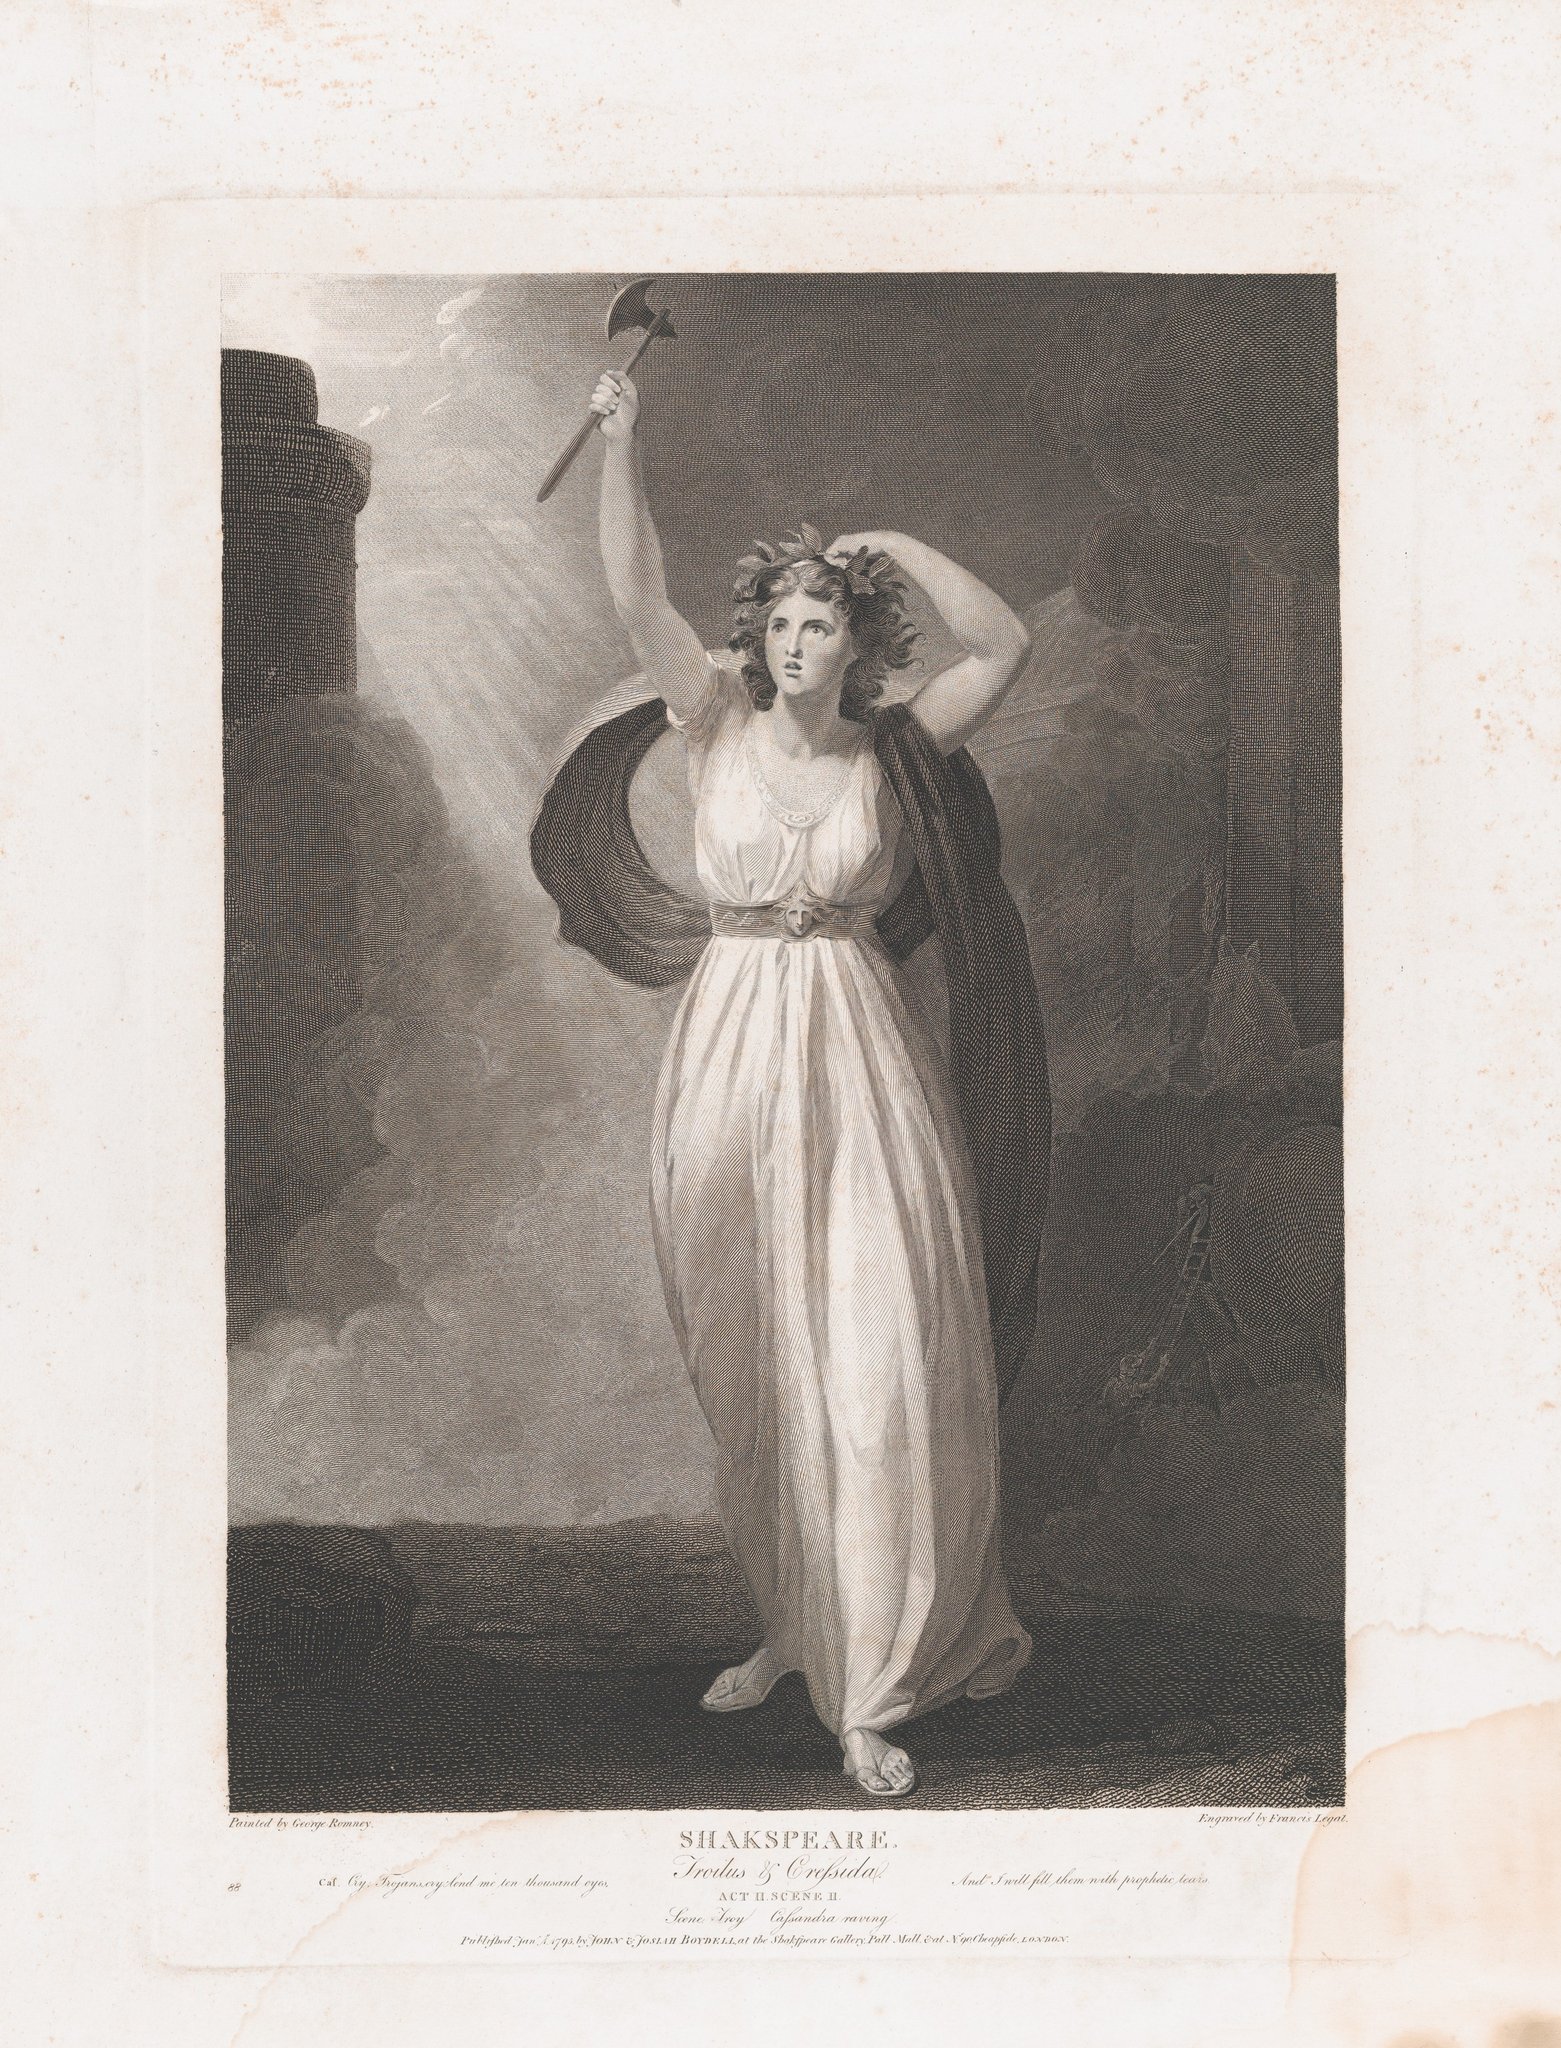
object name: print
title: Cassandra Raving (Shakespeare, Troilus and Cressida, Act 2, Scene 2)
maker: francis legat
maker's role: engraver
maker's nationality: british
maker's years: 1755-1809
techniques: engraving, etching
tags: shakespeare,women